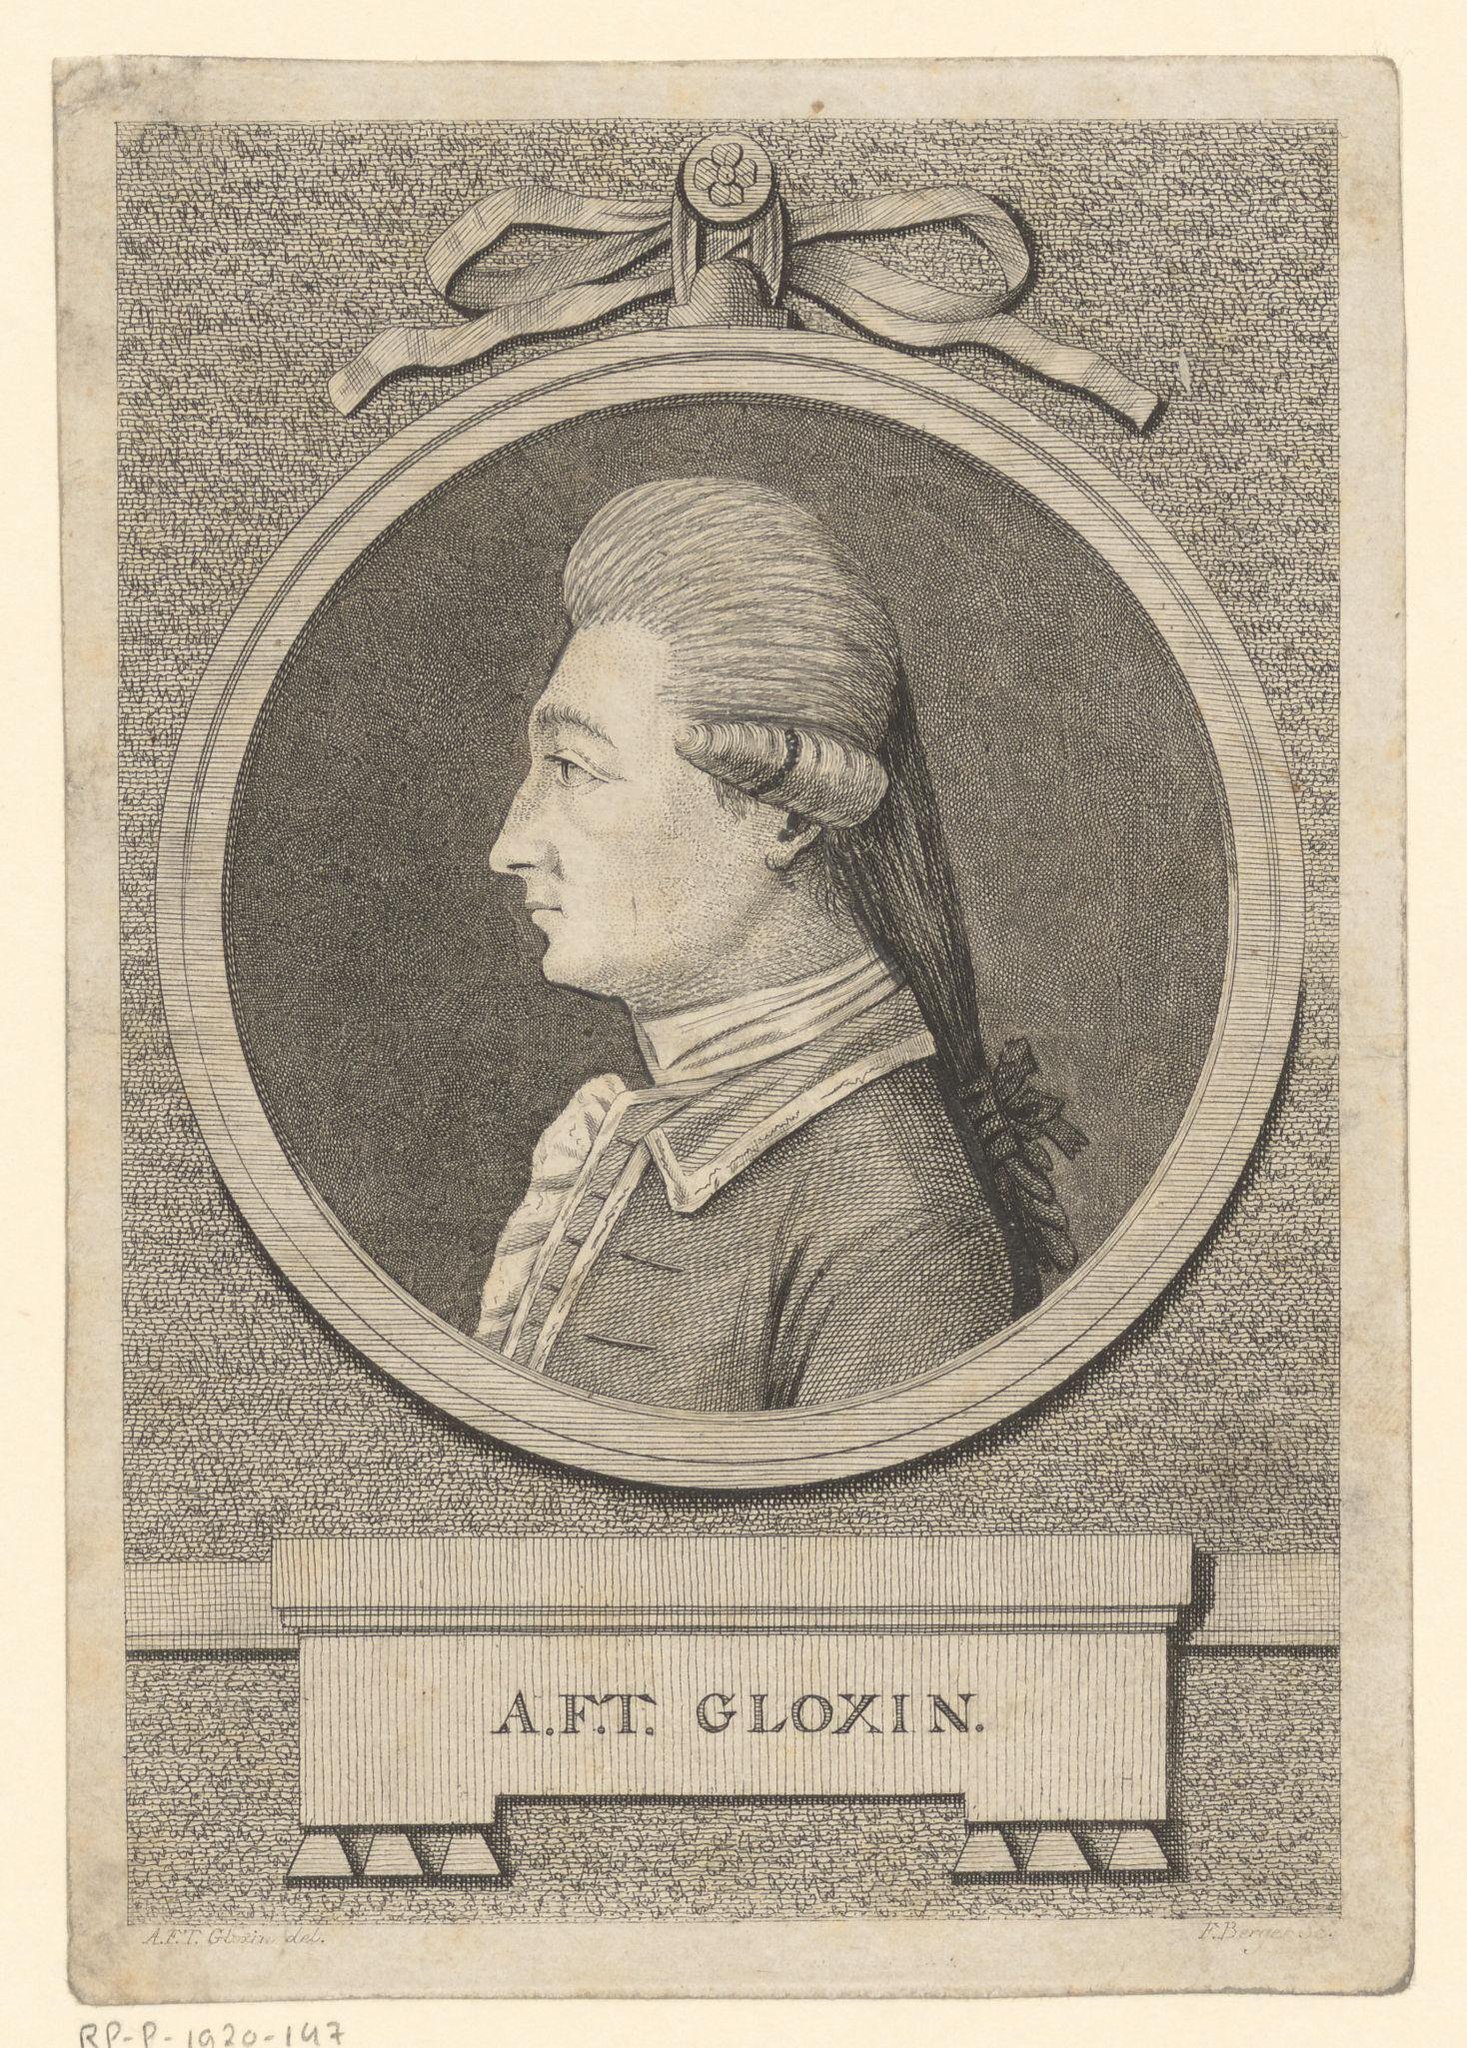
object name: print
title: Portret van A.F.T. Gloxin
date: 1793-1844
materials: paper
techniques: etching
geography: berlin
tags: draughtsman, a.f.t. gloxin, historical persons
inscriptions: collector's mark: Lugt 2228